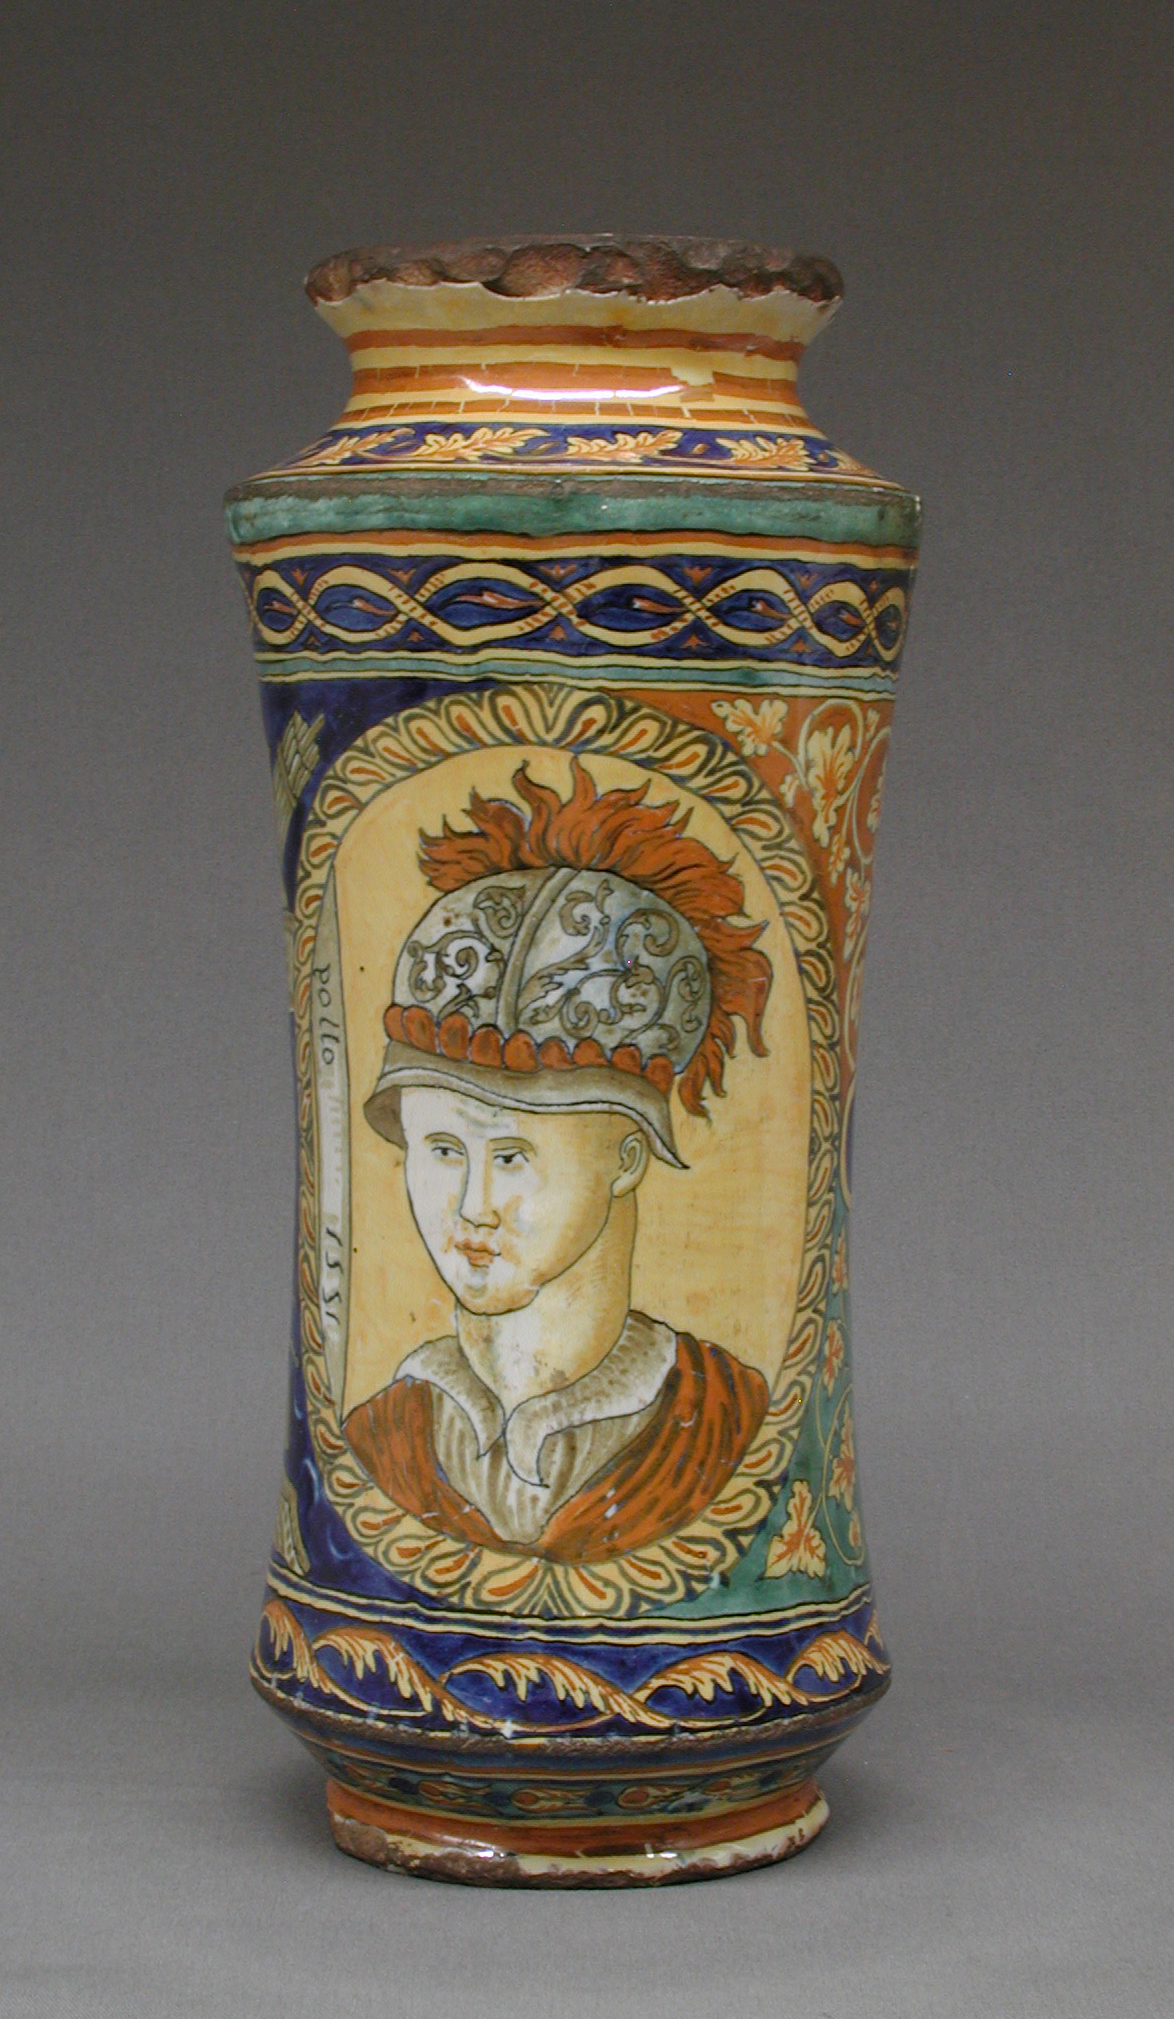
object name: pharmacy jar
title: Pharmacy jar (albarello)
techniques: maiolica, glazing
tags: armor,men,portraits